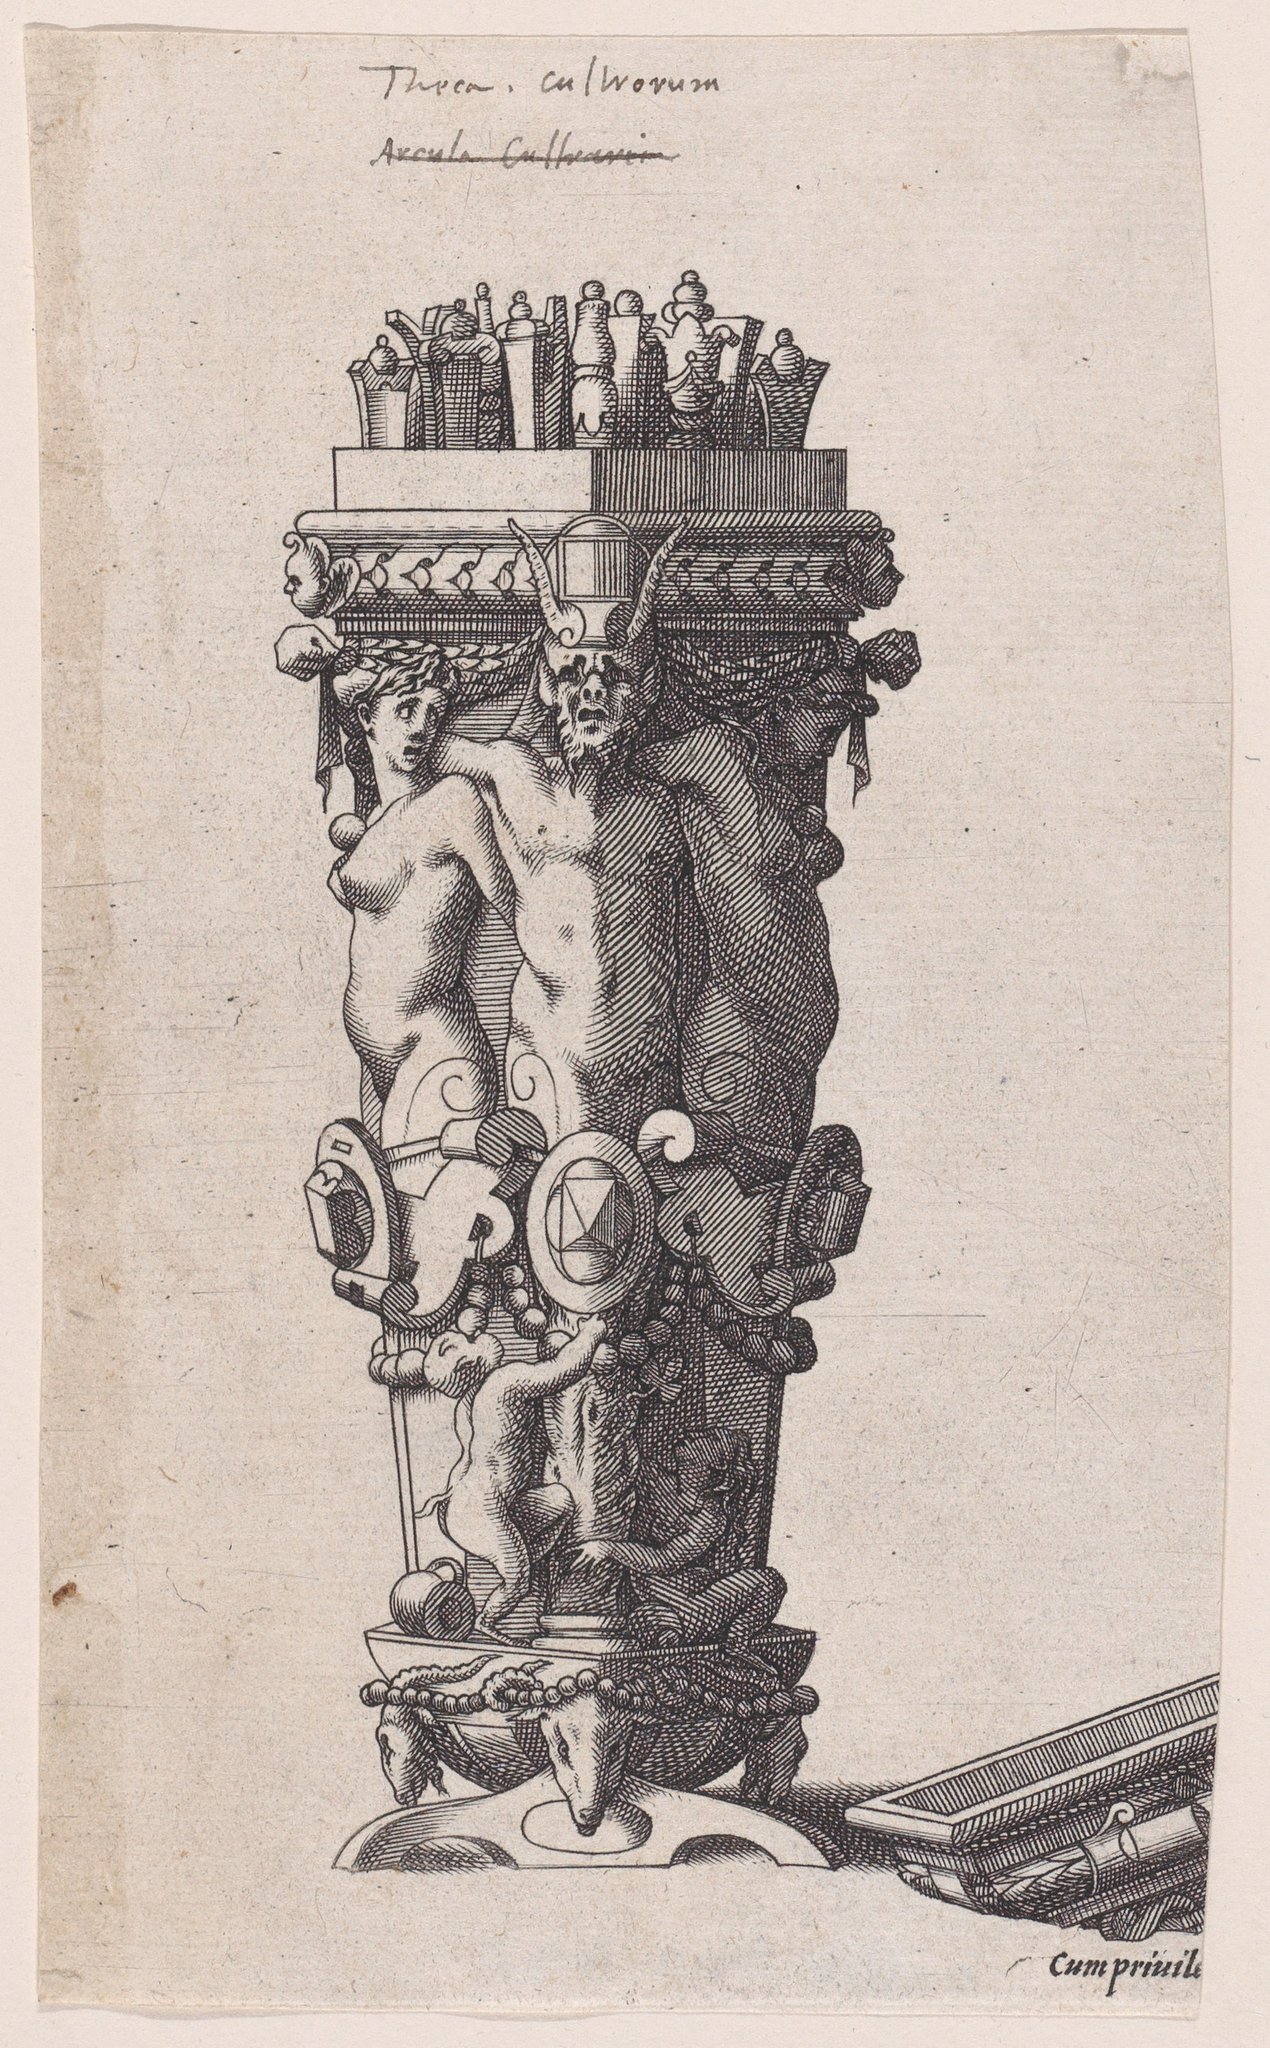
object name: print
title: Container with a Satyr (Nécessaire de table)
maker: rené boyvin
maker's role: artist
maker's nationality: french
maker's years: 1525-1598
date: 1525-1600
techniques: engraving